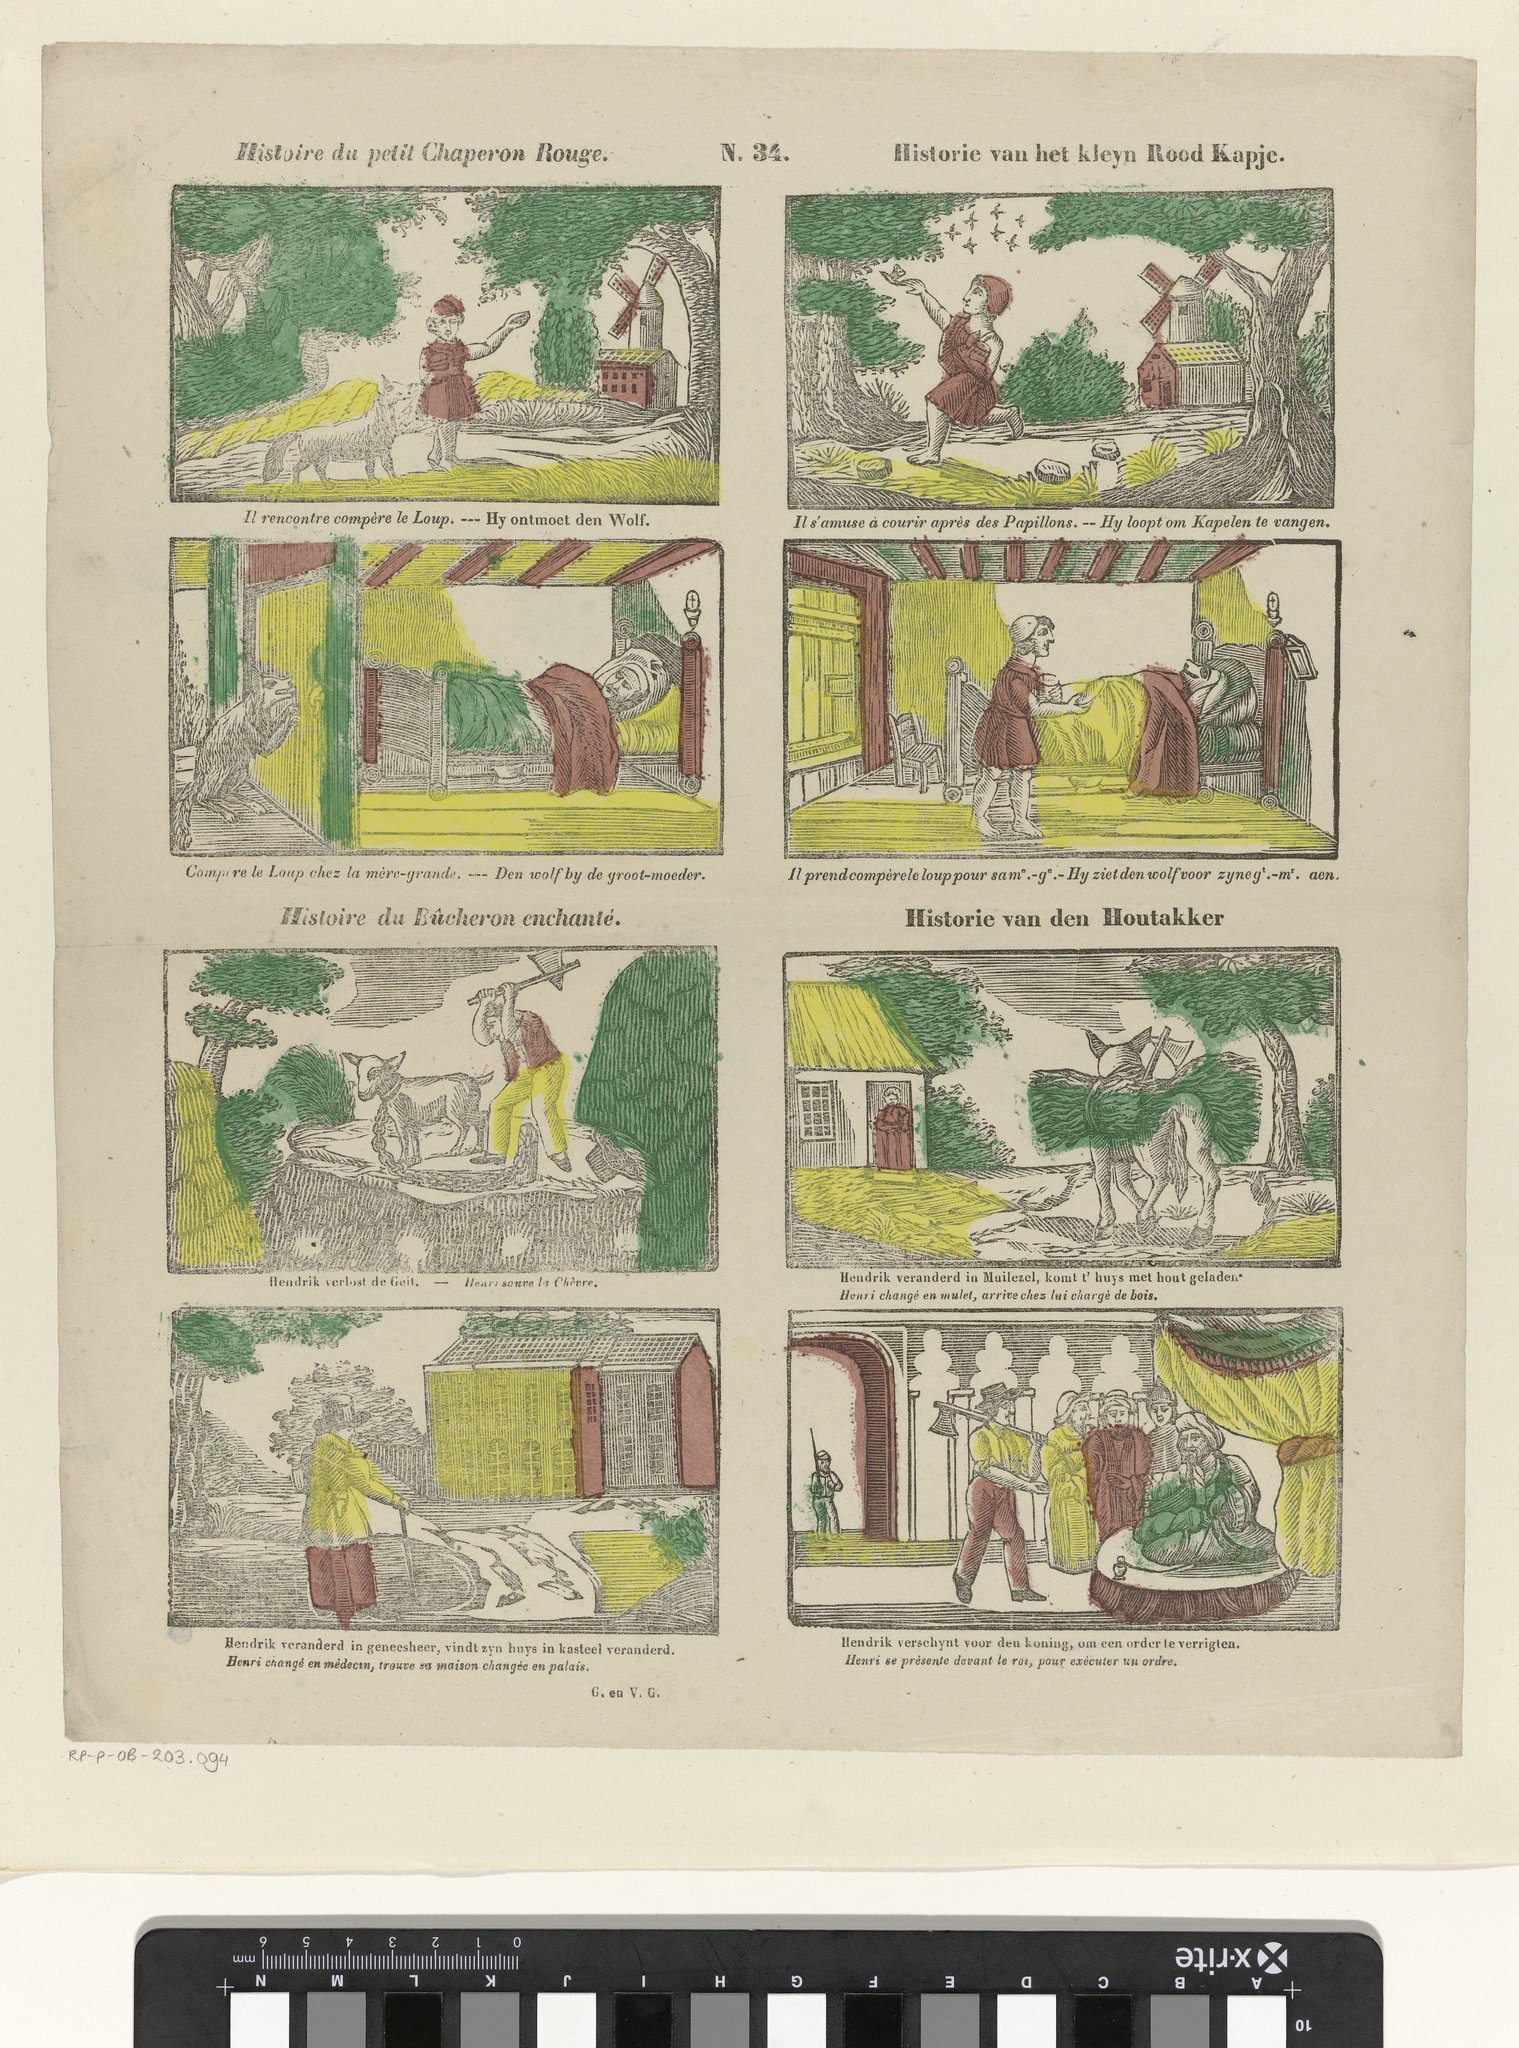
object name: popular print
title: Histoire du petit Chaperon Rouge / Historie van het kleyn Rood Kapje / Histoire du bûcheron enchanté / Historie van den houthakker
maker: Anonymous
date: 1833-1856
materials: paper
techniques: colour, letterpress printing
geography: turnhout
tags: tales and fairy tales, tales and fairy tales: little red riding-hood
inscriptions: collector's mark: Lugt 2760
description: Blad met 4 voorstellingen uit het sprookje van Roodkapje en 4 voorstellingen uit het sprookje van de houthakker. Onder elke afbeelding een onderschrift in het Nederlands en in het Frans. Genummerd midden boven: N. 34.